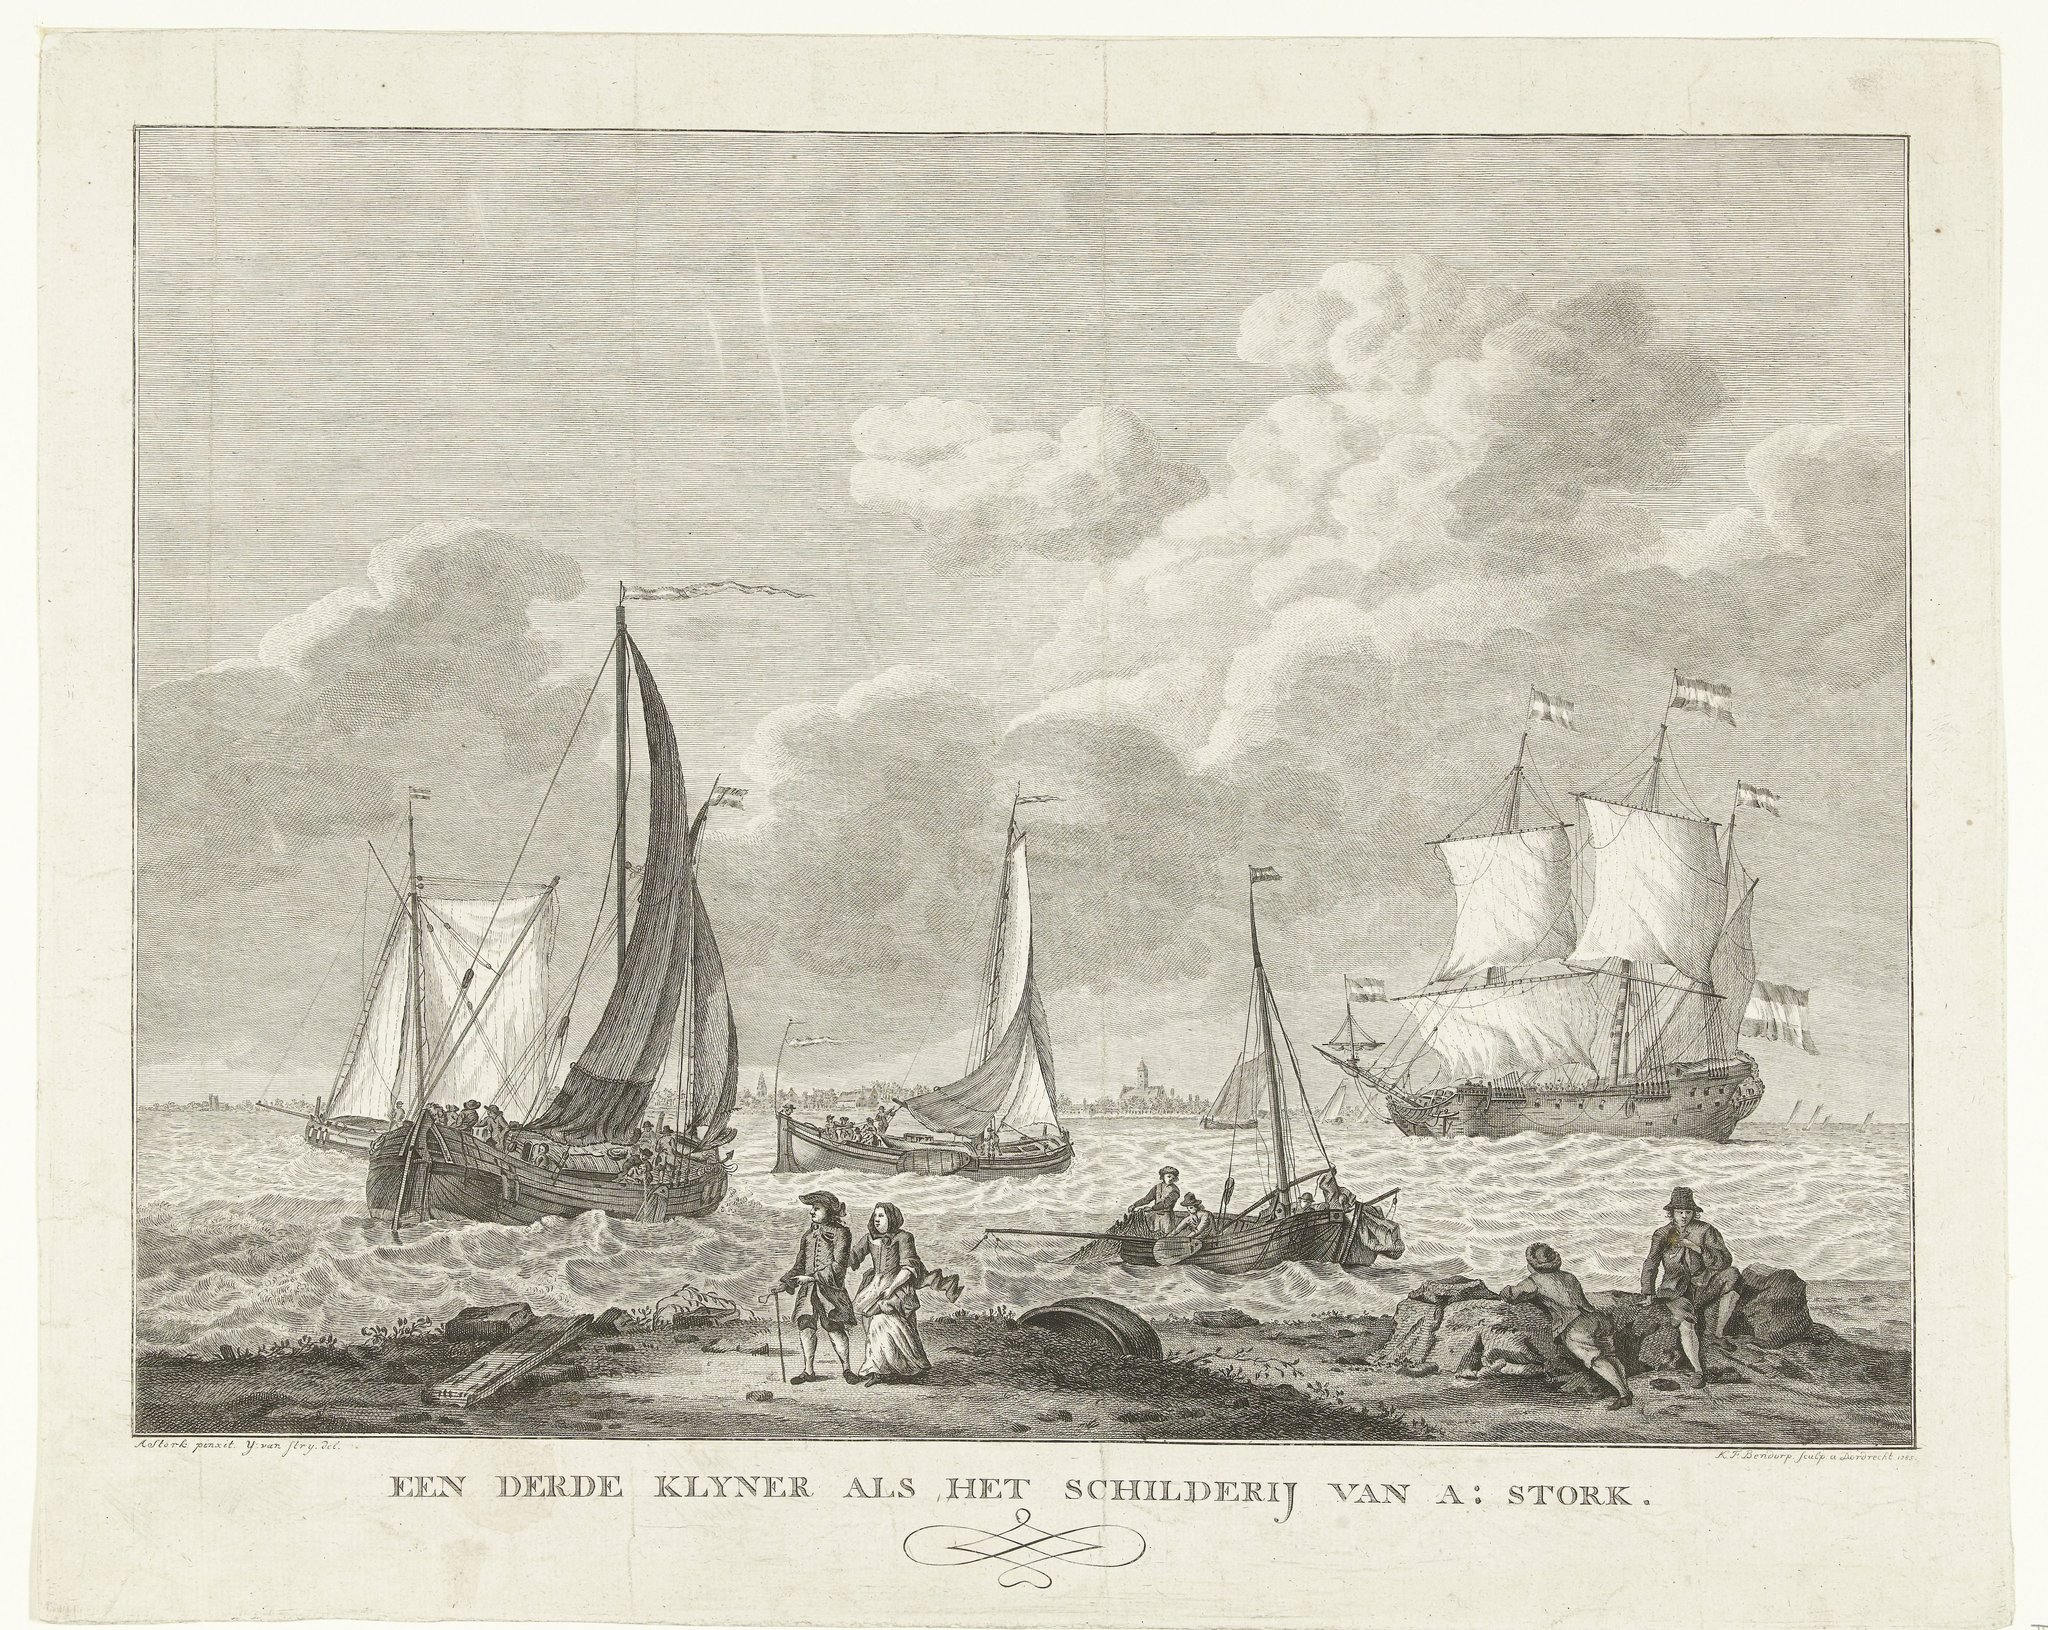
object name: print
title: Een derde klyner als het schilderij van A: Storck.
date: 1785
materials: paper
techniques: etching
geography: dordrecht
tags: sea (seascape), walking arm in arm, historical disciplines; philology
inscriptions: collector's mark: Lugt 2228